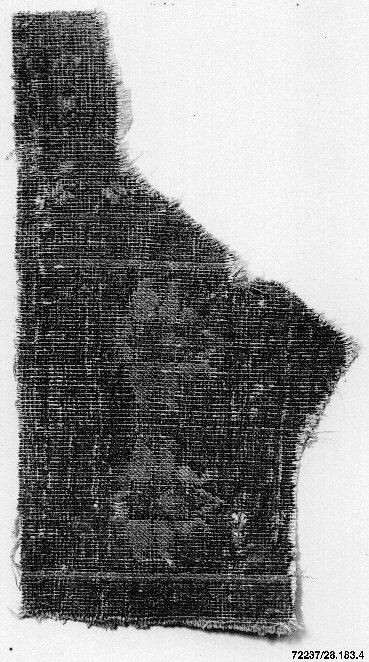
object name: carpet fragment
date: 1501-1600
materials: wool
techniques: asymmetrically knotted pile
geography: egypt